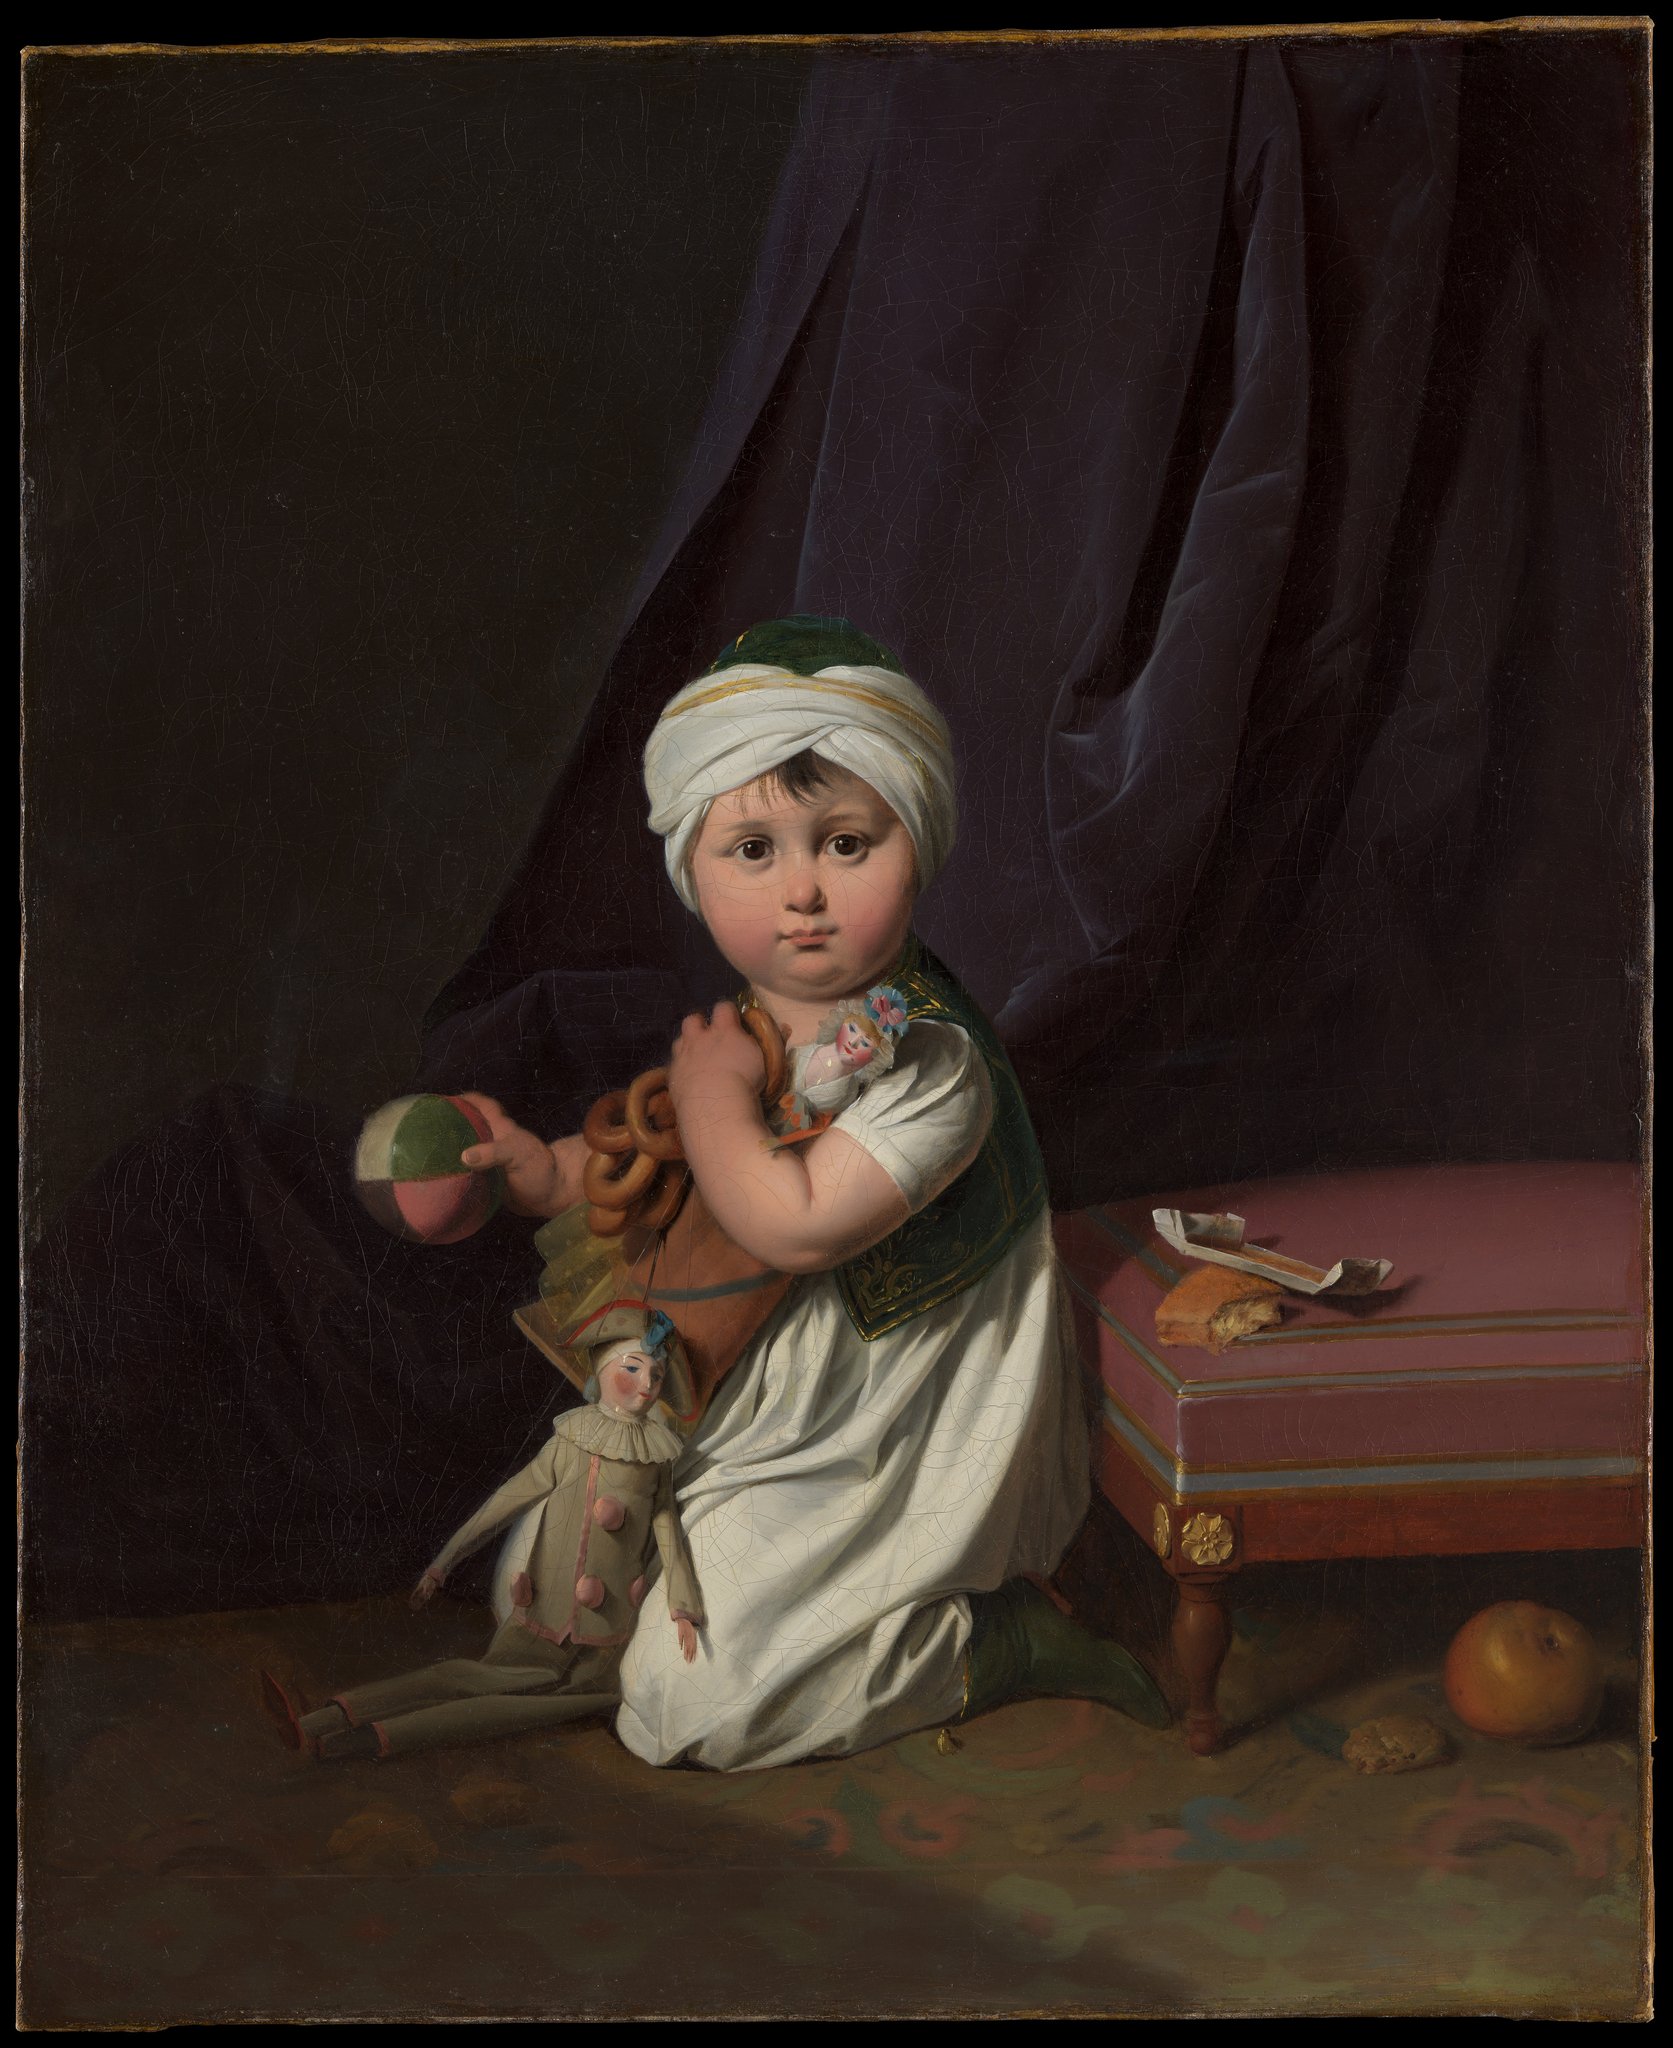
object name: painting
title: Portrait of a Boy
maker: louis léopold boilly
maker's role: artist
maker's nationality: french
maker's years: 1761-1845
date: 1805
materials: canvas, oil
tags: apples,boys,dolls,stools,cakes